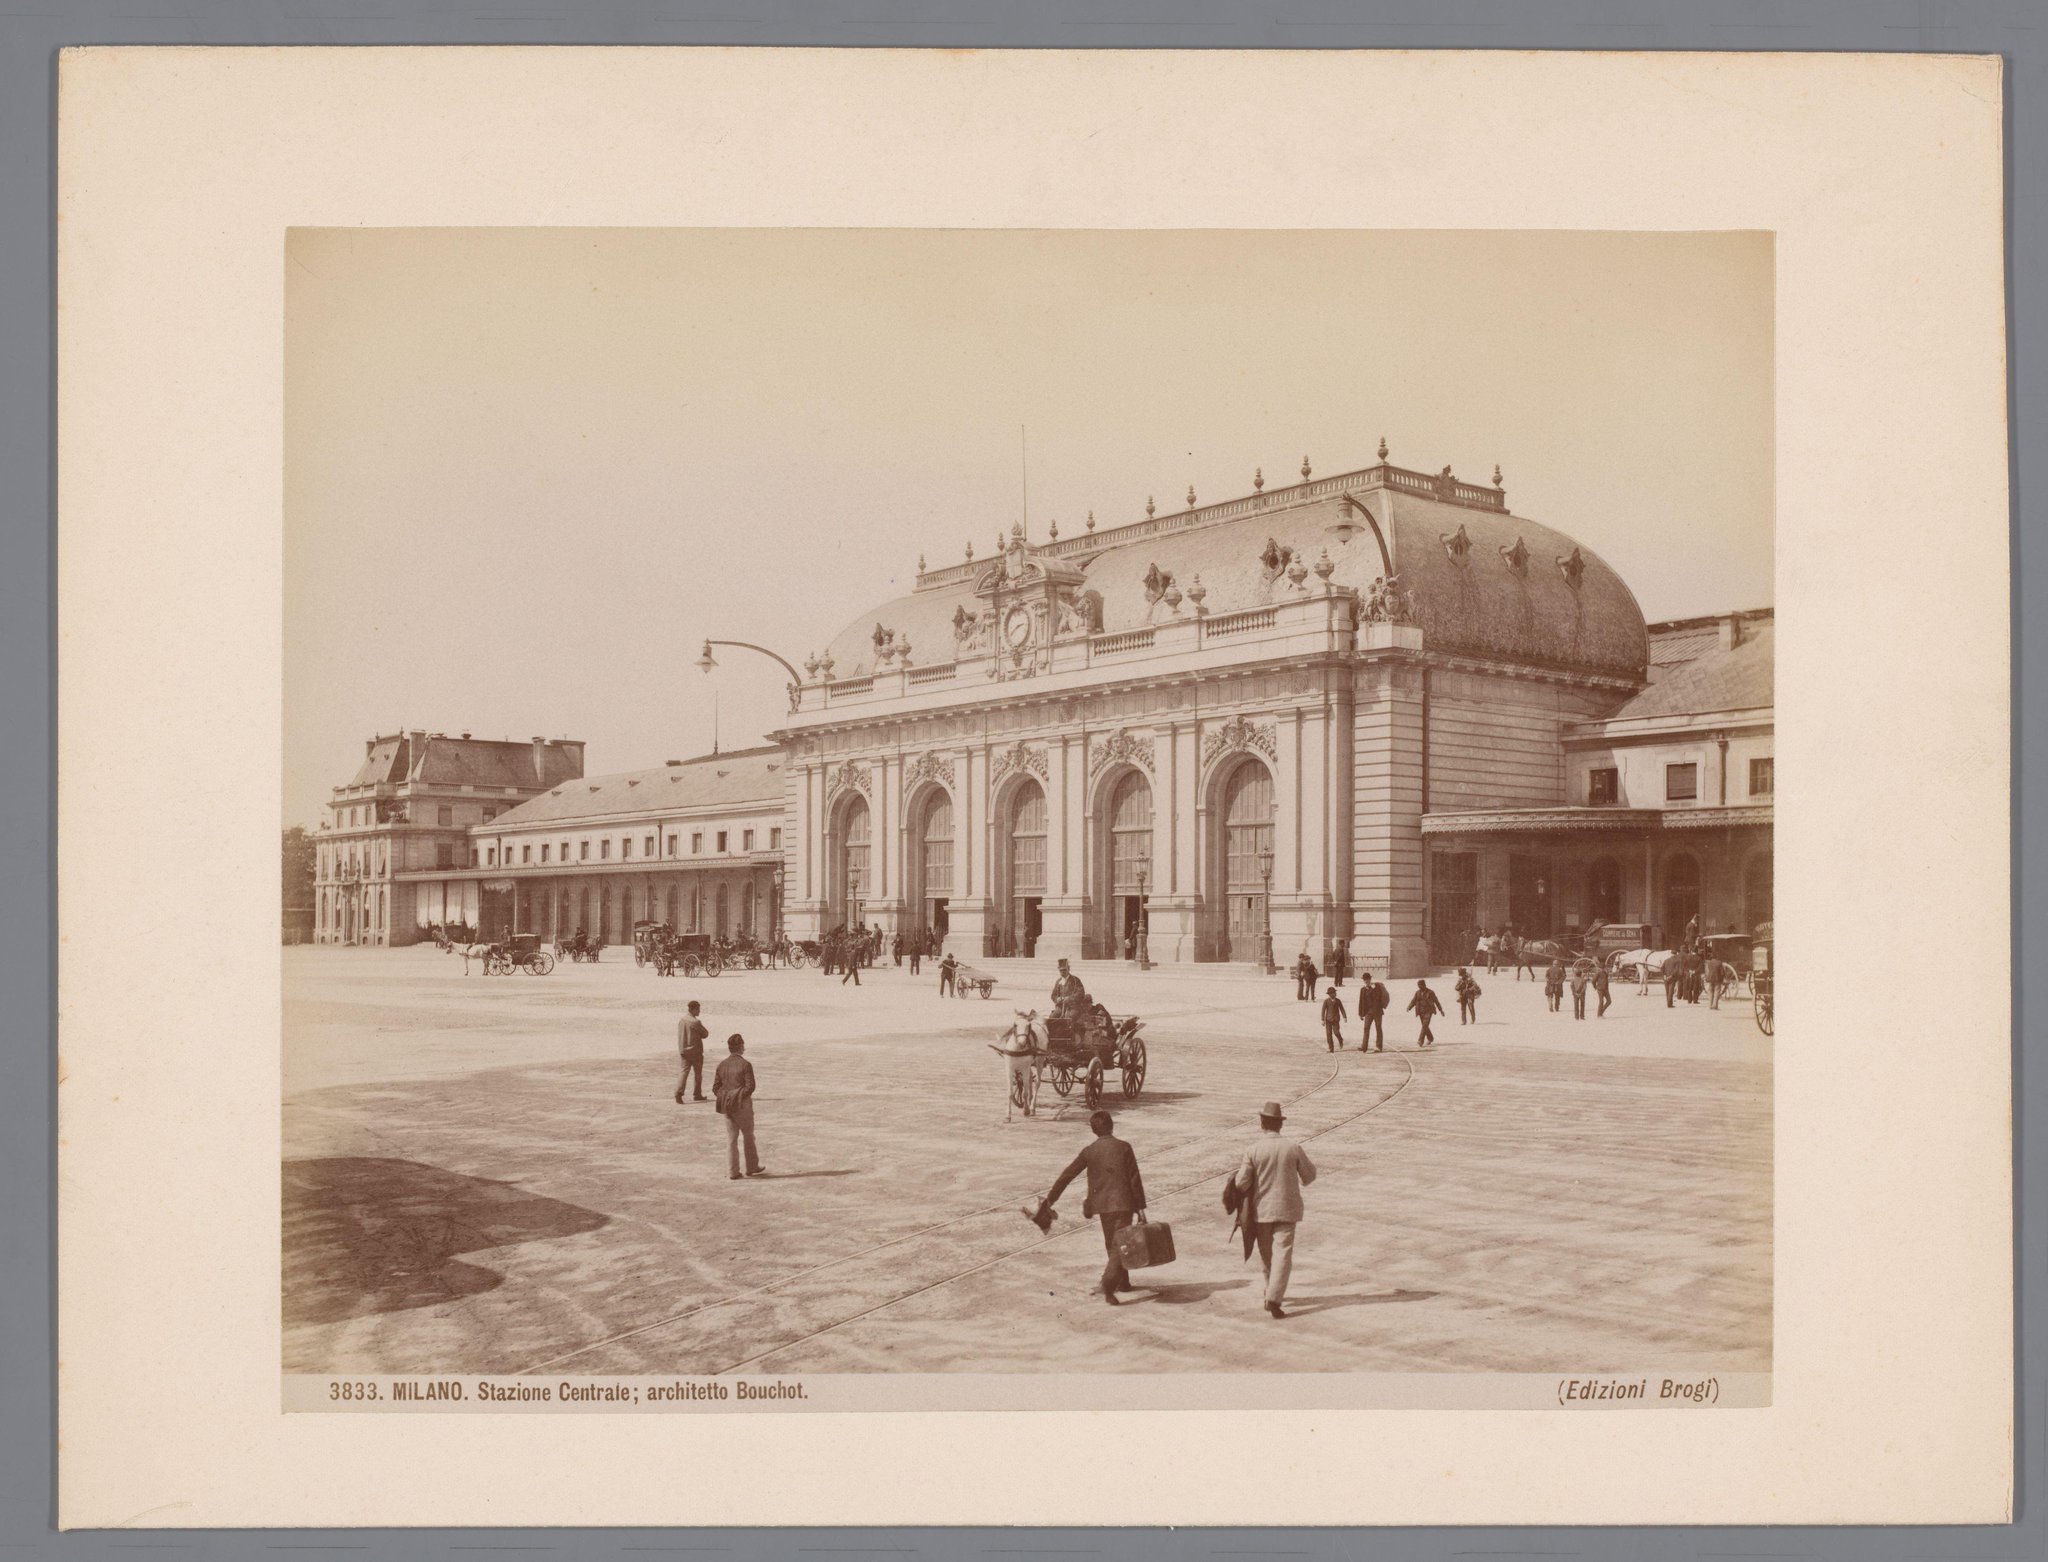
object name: photograph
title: Gezicht op het station van Milaan, Italië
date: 1864-1881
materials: cardboard, paper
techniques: albumen print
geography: milan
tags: exterior ~ representation of a building, station; shelter (railway, tramway)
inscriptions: number: ‘3833.’, inscription: ‘(Diepr. nagekomen)’